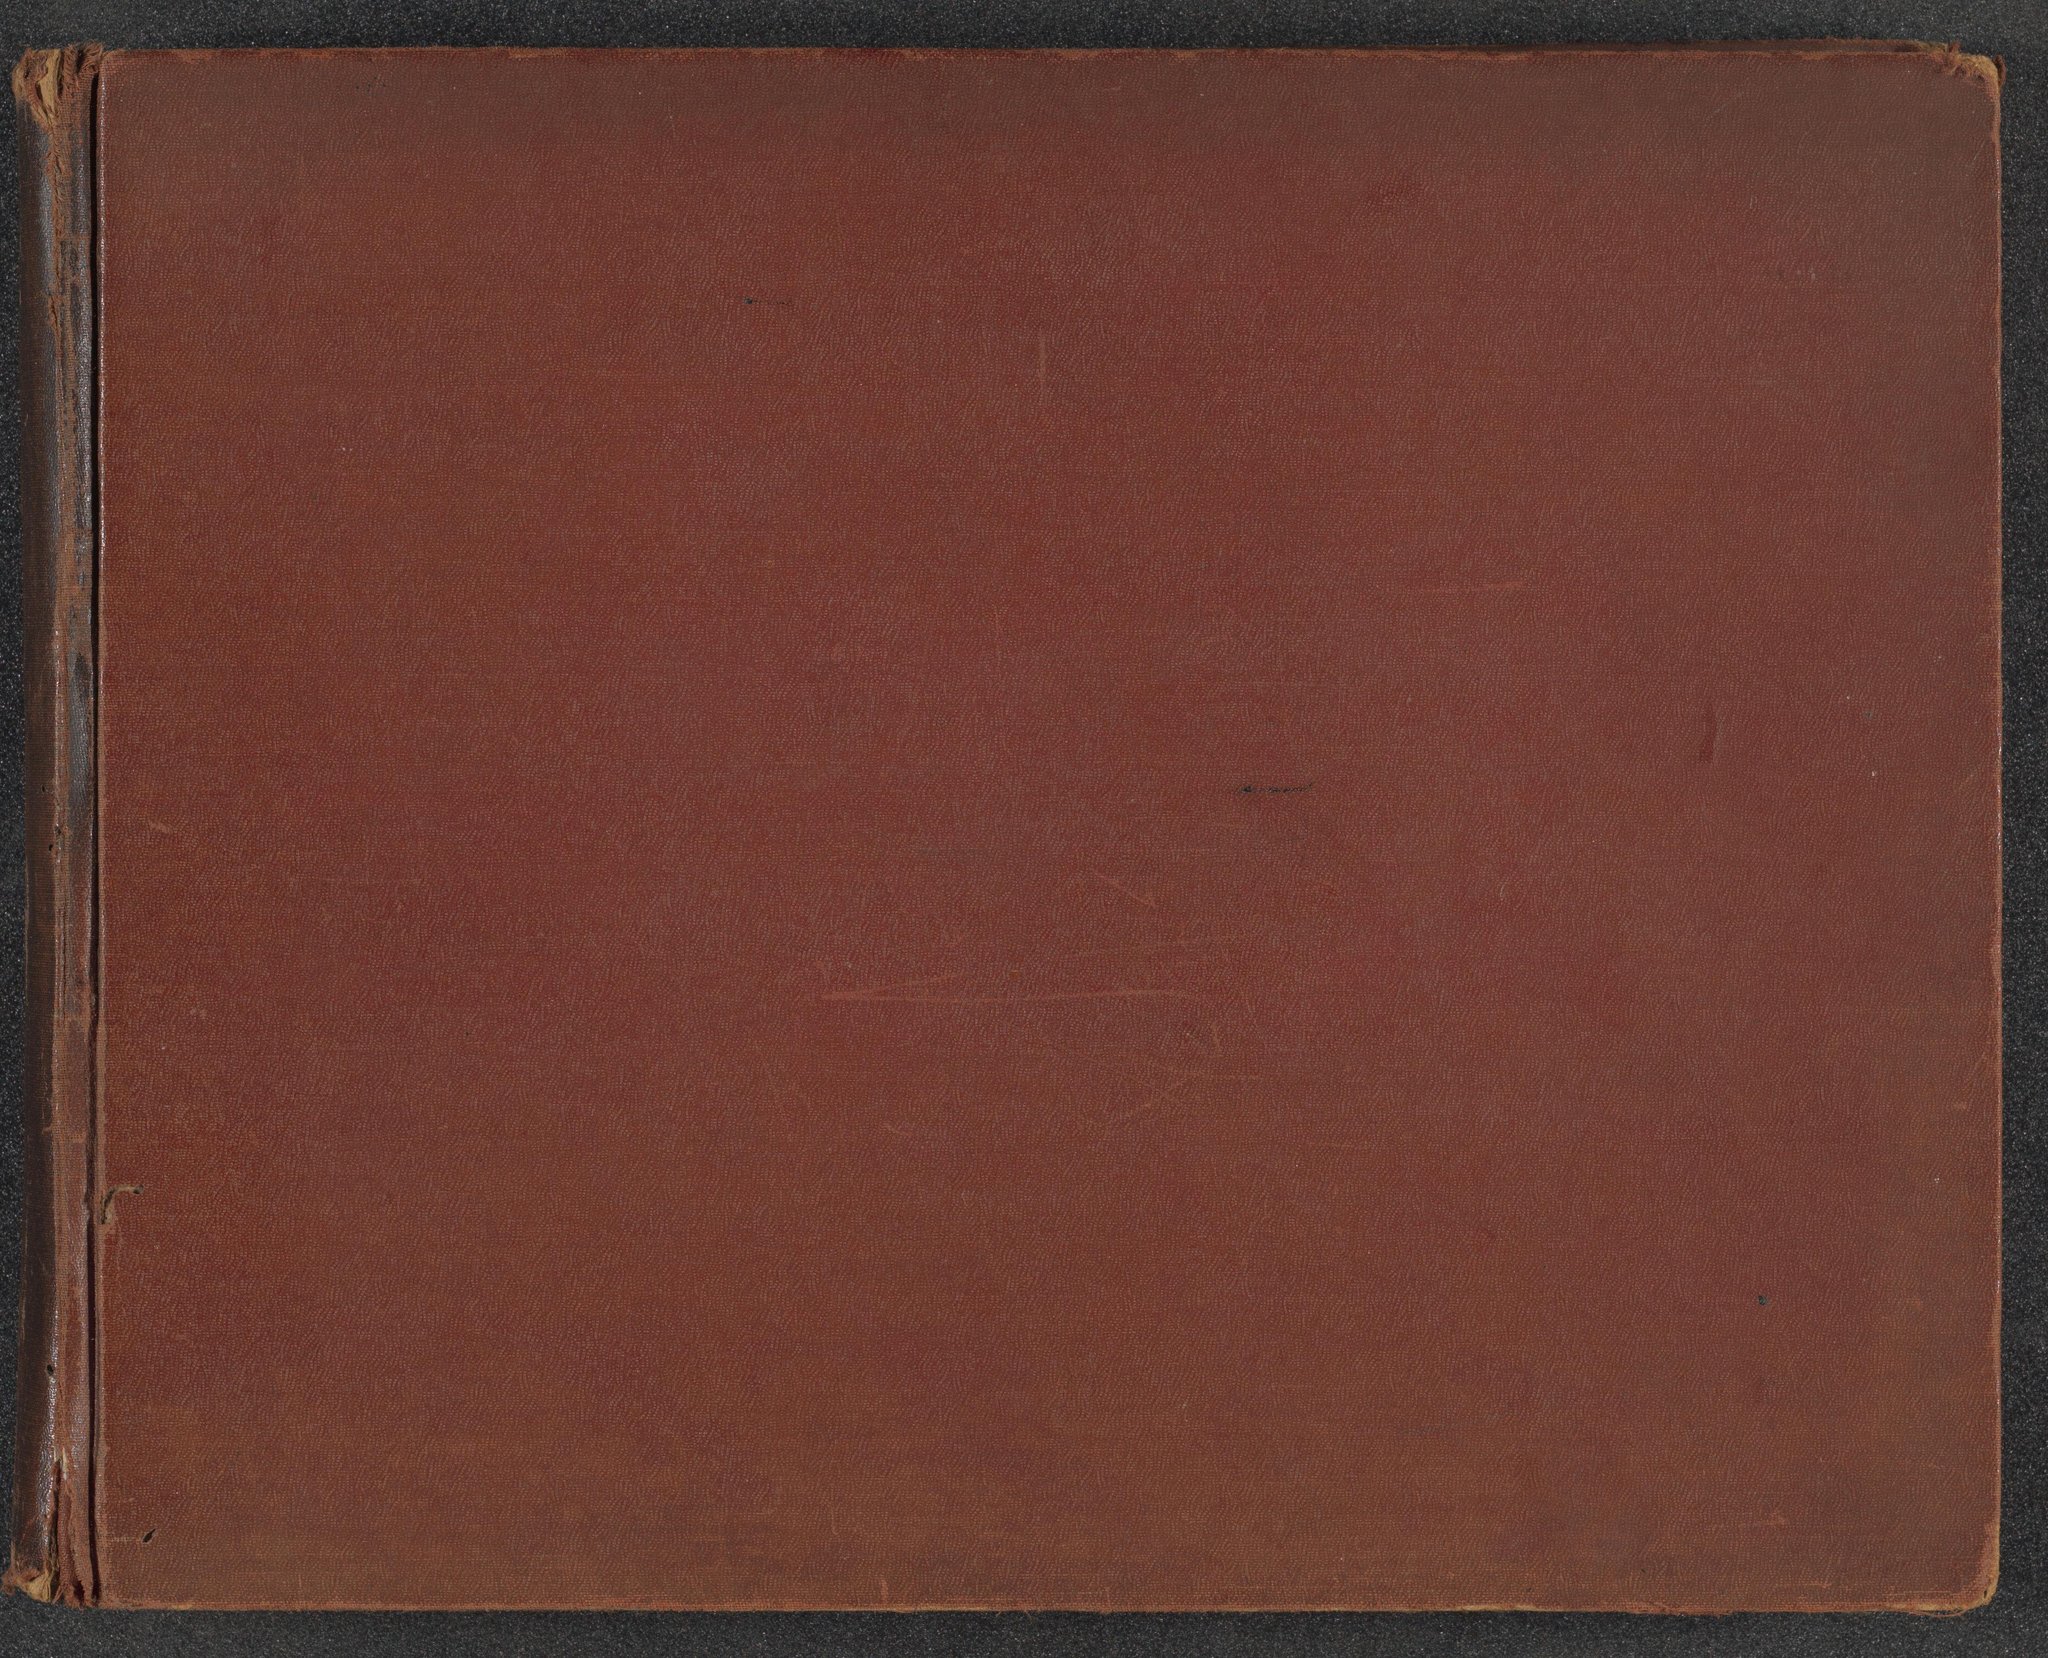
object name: book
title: Fotoboek van de Algemeene Vereeniging van Rubberplanters ter Oostkust van Sumatra (A.V.R.O.S.)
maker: j.w. meyster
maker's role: fotograaf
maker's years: 1887-1945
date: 1924-1925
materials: cardboard, paper, photographic support, textile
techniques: printing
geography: dutch east indies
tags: plantation, (non-fruit) products of plants or trees: rubber, sumatra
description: Fotoboek in roodbruin omslag met 161 genummerde pagina's. De schutbladen hebben een geometrisch motief. Het fotoalbum werd aangeboden aan gouverneur-generaal van Nederlands-Indië mr. D. Fock door de Algemeene Vereeniging van Rubberplanters ter Oostkust van Sumatra (A.V.R.O.S.). Anders dan de naam doet vermoeden behartigde deze organisatie ook de belangen van andere planters en cultures in Nederlands-Indië. Het album geeft in korte teksten en in 127 foto's een beeld van de A.V.R.O.S. en de productiewijzen van de rubber, thee, koffie, oliepalmen, vezel, kokos, gambir en guttapercha.